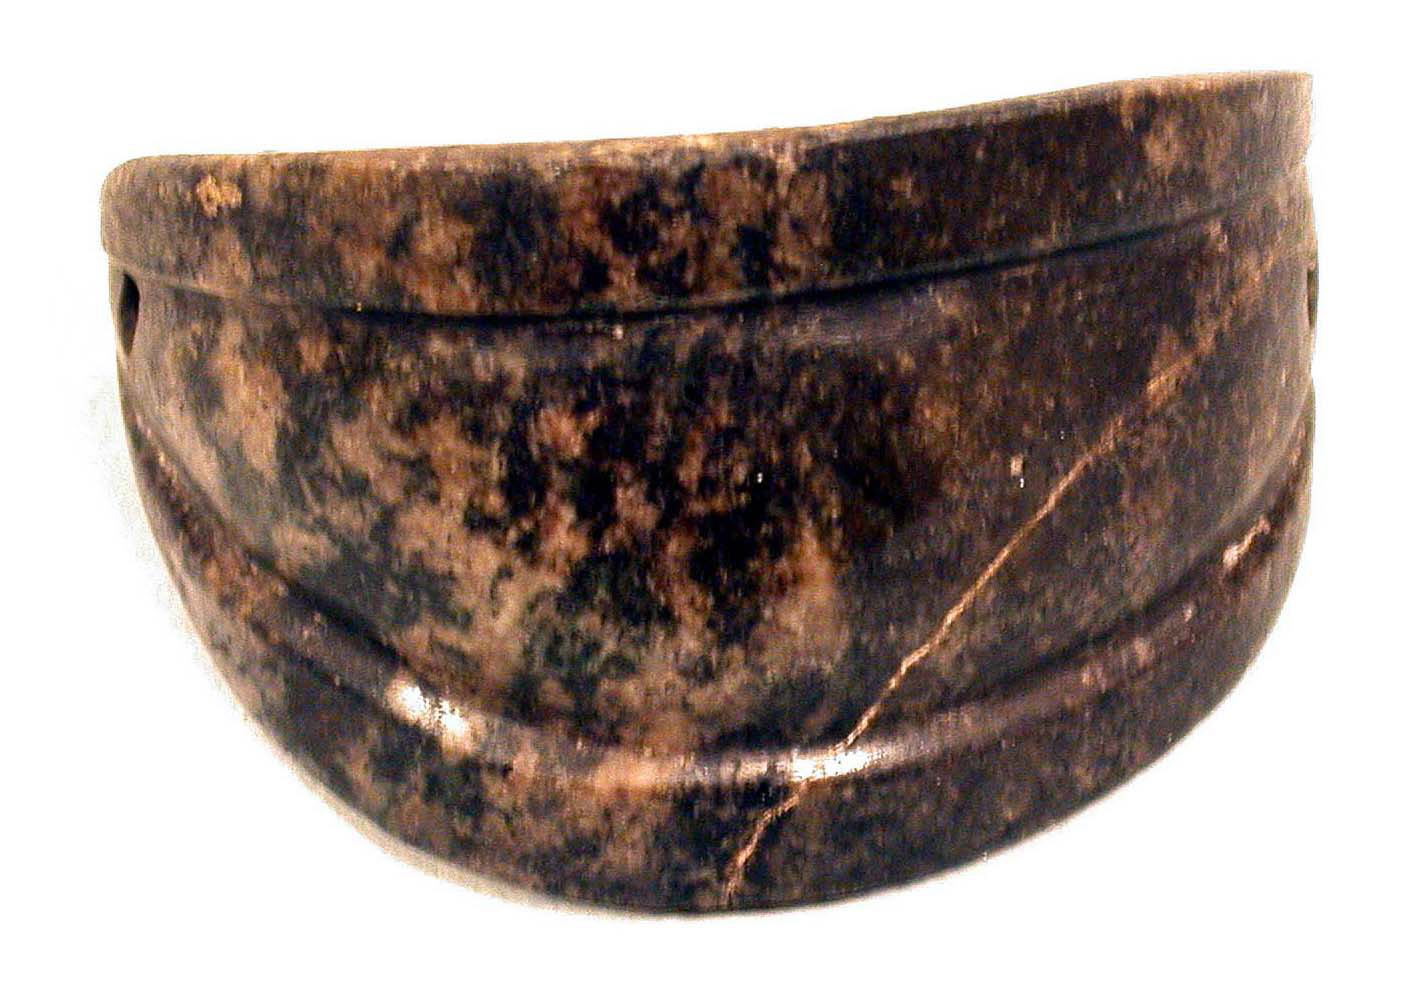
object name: finger grip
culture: mexican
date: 1501-1600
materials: stone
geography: mexico